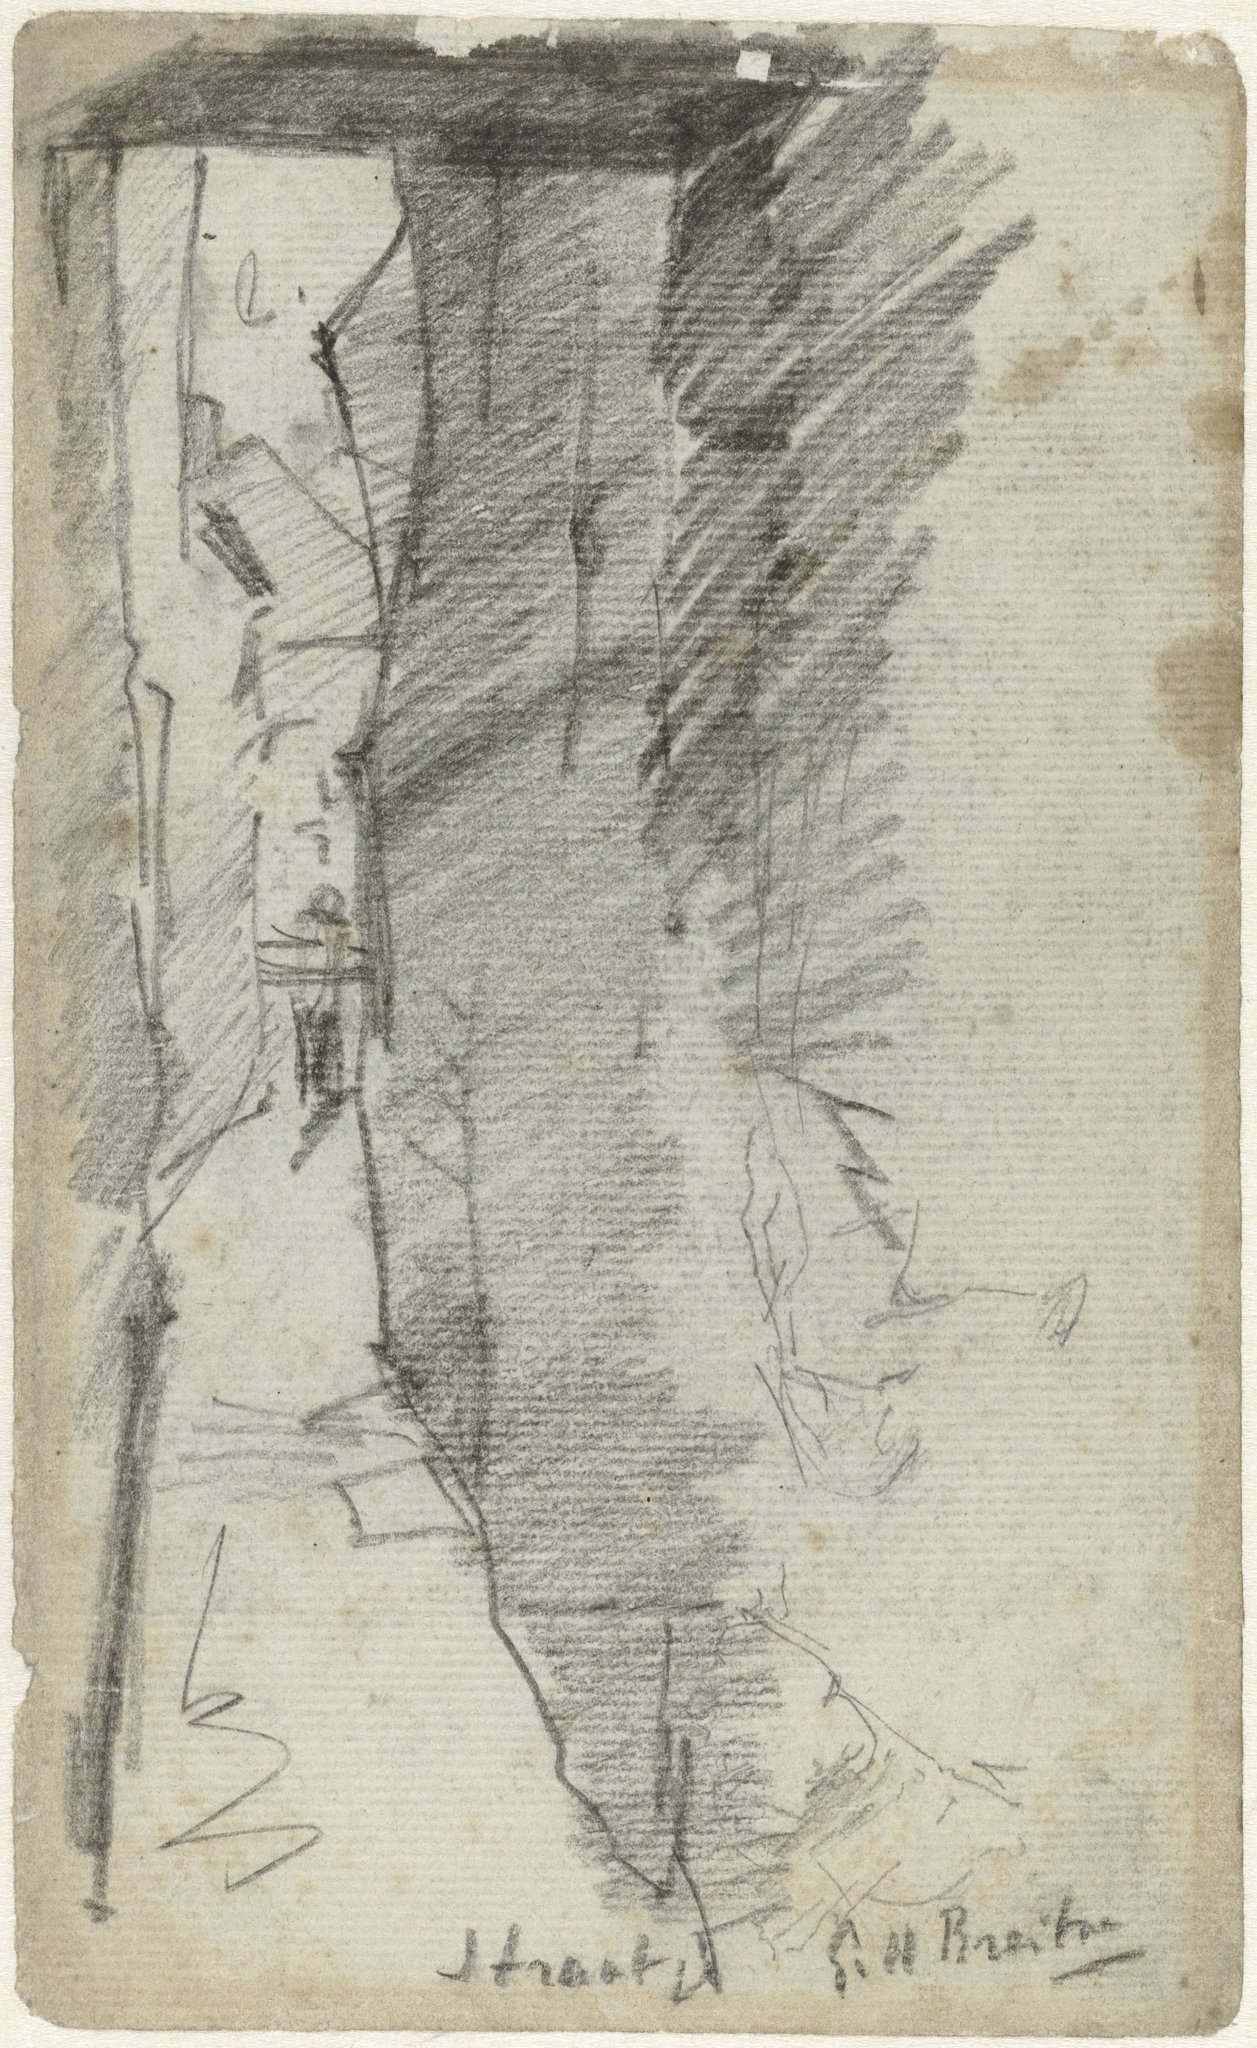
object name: drawing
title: Straatje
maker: george hendrik breitner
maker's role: draughtsman, painter, print maker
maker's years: 1857-1923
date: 1867-1923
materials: chalk, paper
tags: street